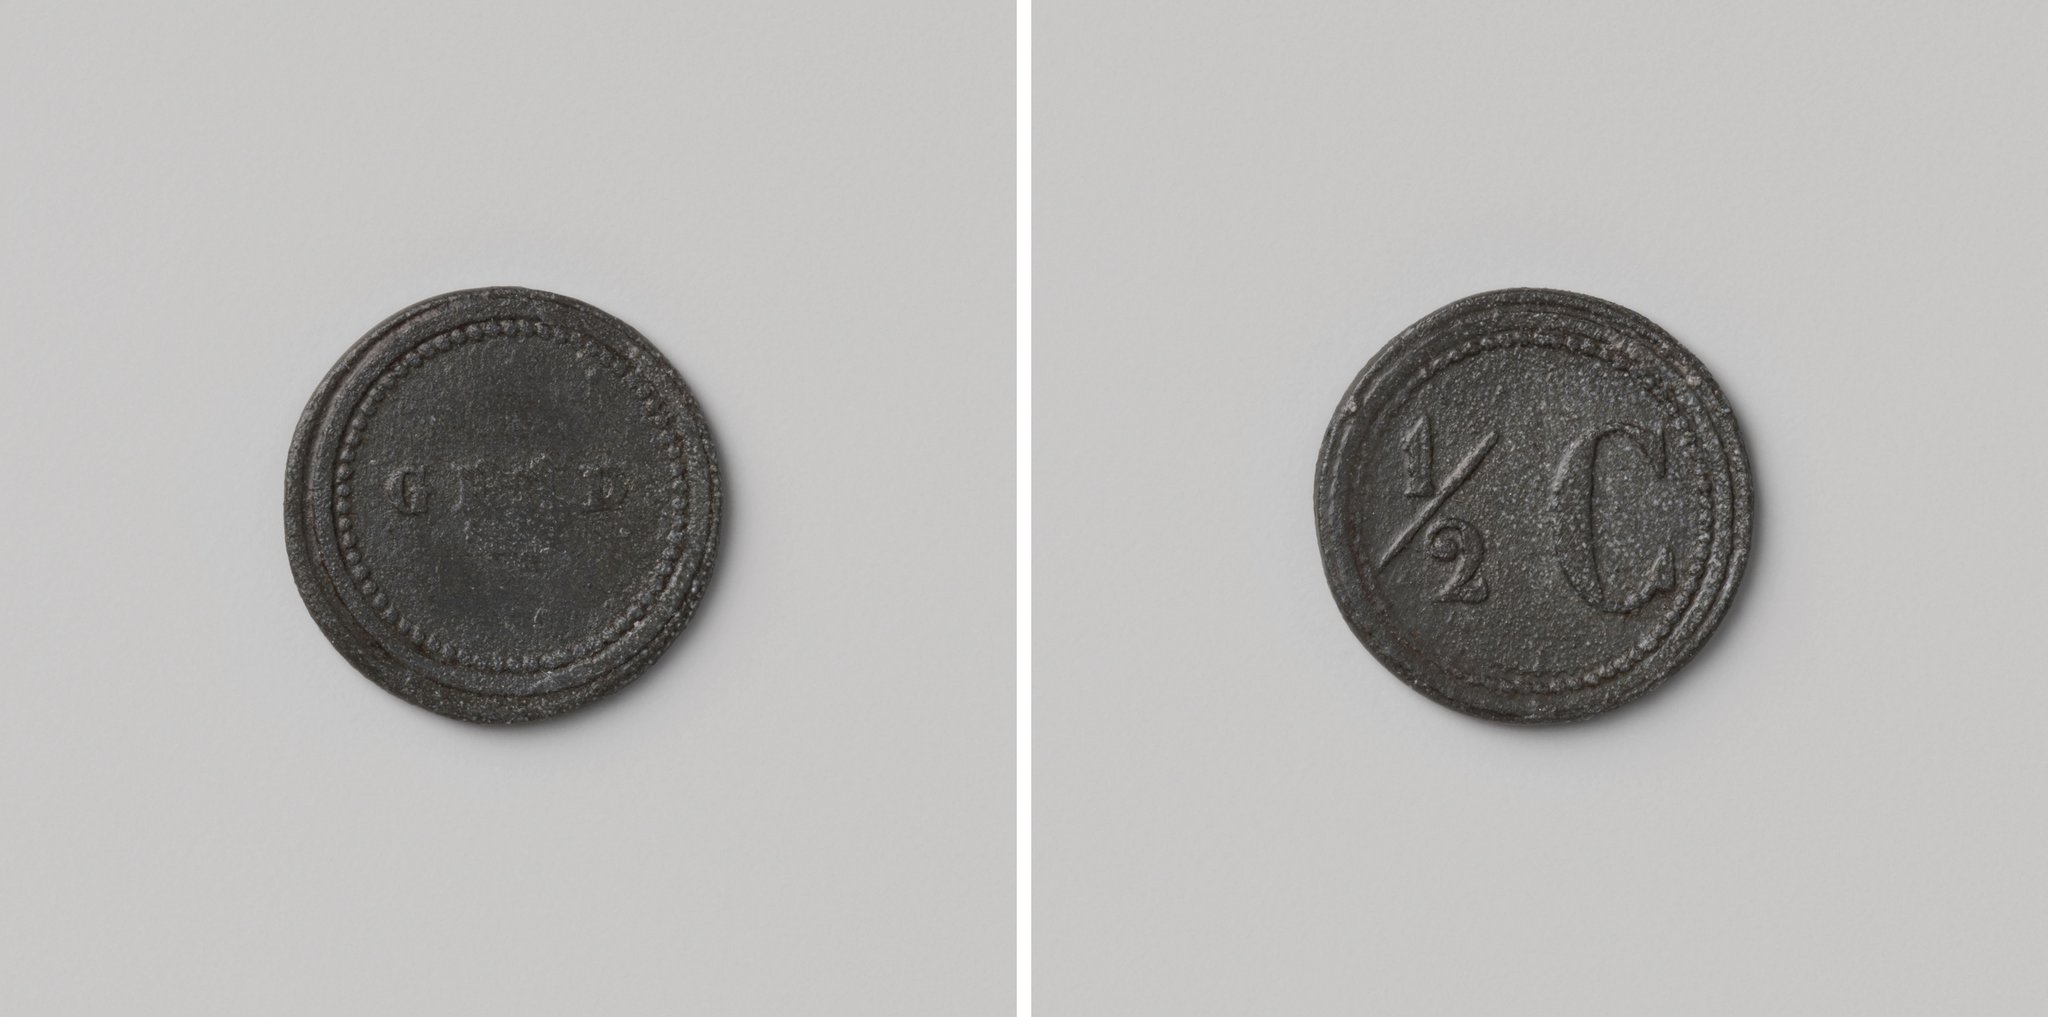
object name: halve cent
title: Strafgevangenis te Gent, huismunt ter waarde van een halve cent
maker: Anonymous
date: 1826-1833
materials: zinc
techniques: striking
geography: brussels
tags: ghent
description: Zinken betaalpenning. Voorzijde: opschrift binnen omschrift. Keerzijde: waardeaanduiding